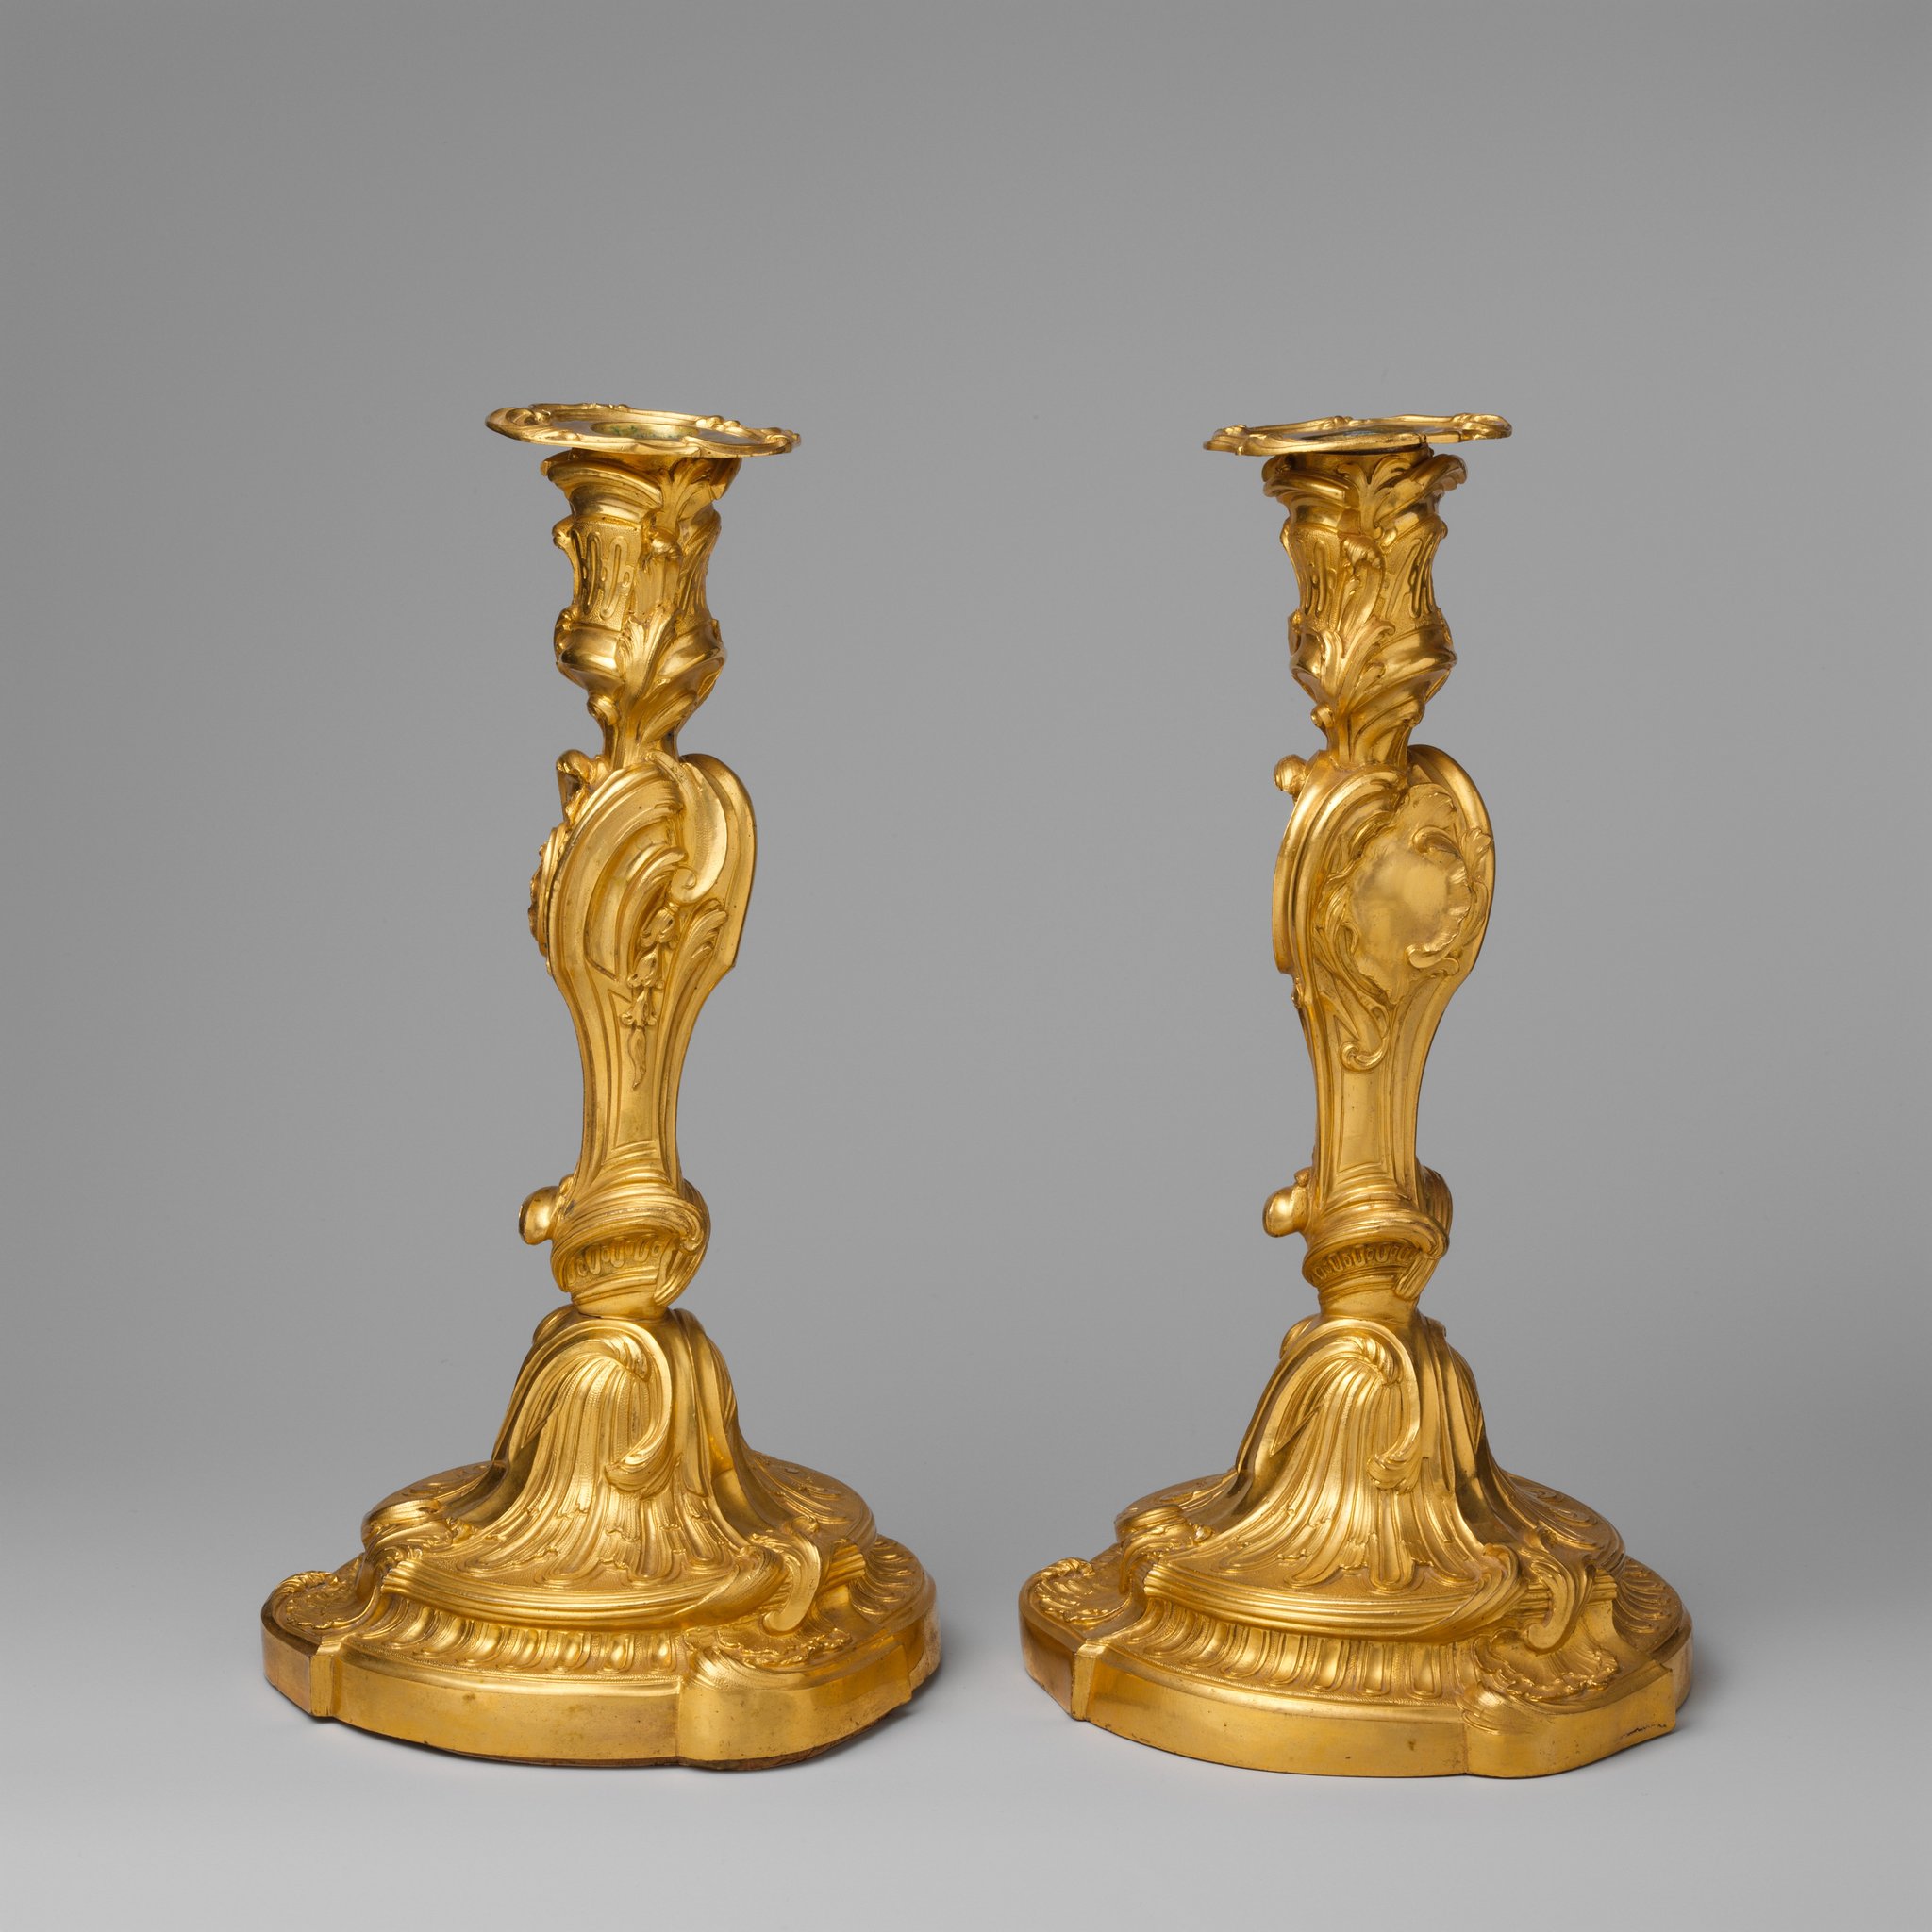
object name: candlestick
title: Pair of candlesticks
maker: juste aurèle meissonnier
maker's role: maker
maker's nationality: french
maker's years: 1695-1750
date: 1735-1750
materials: gilt bronze